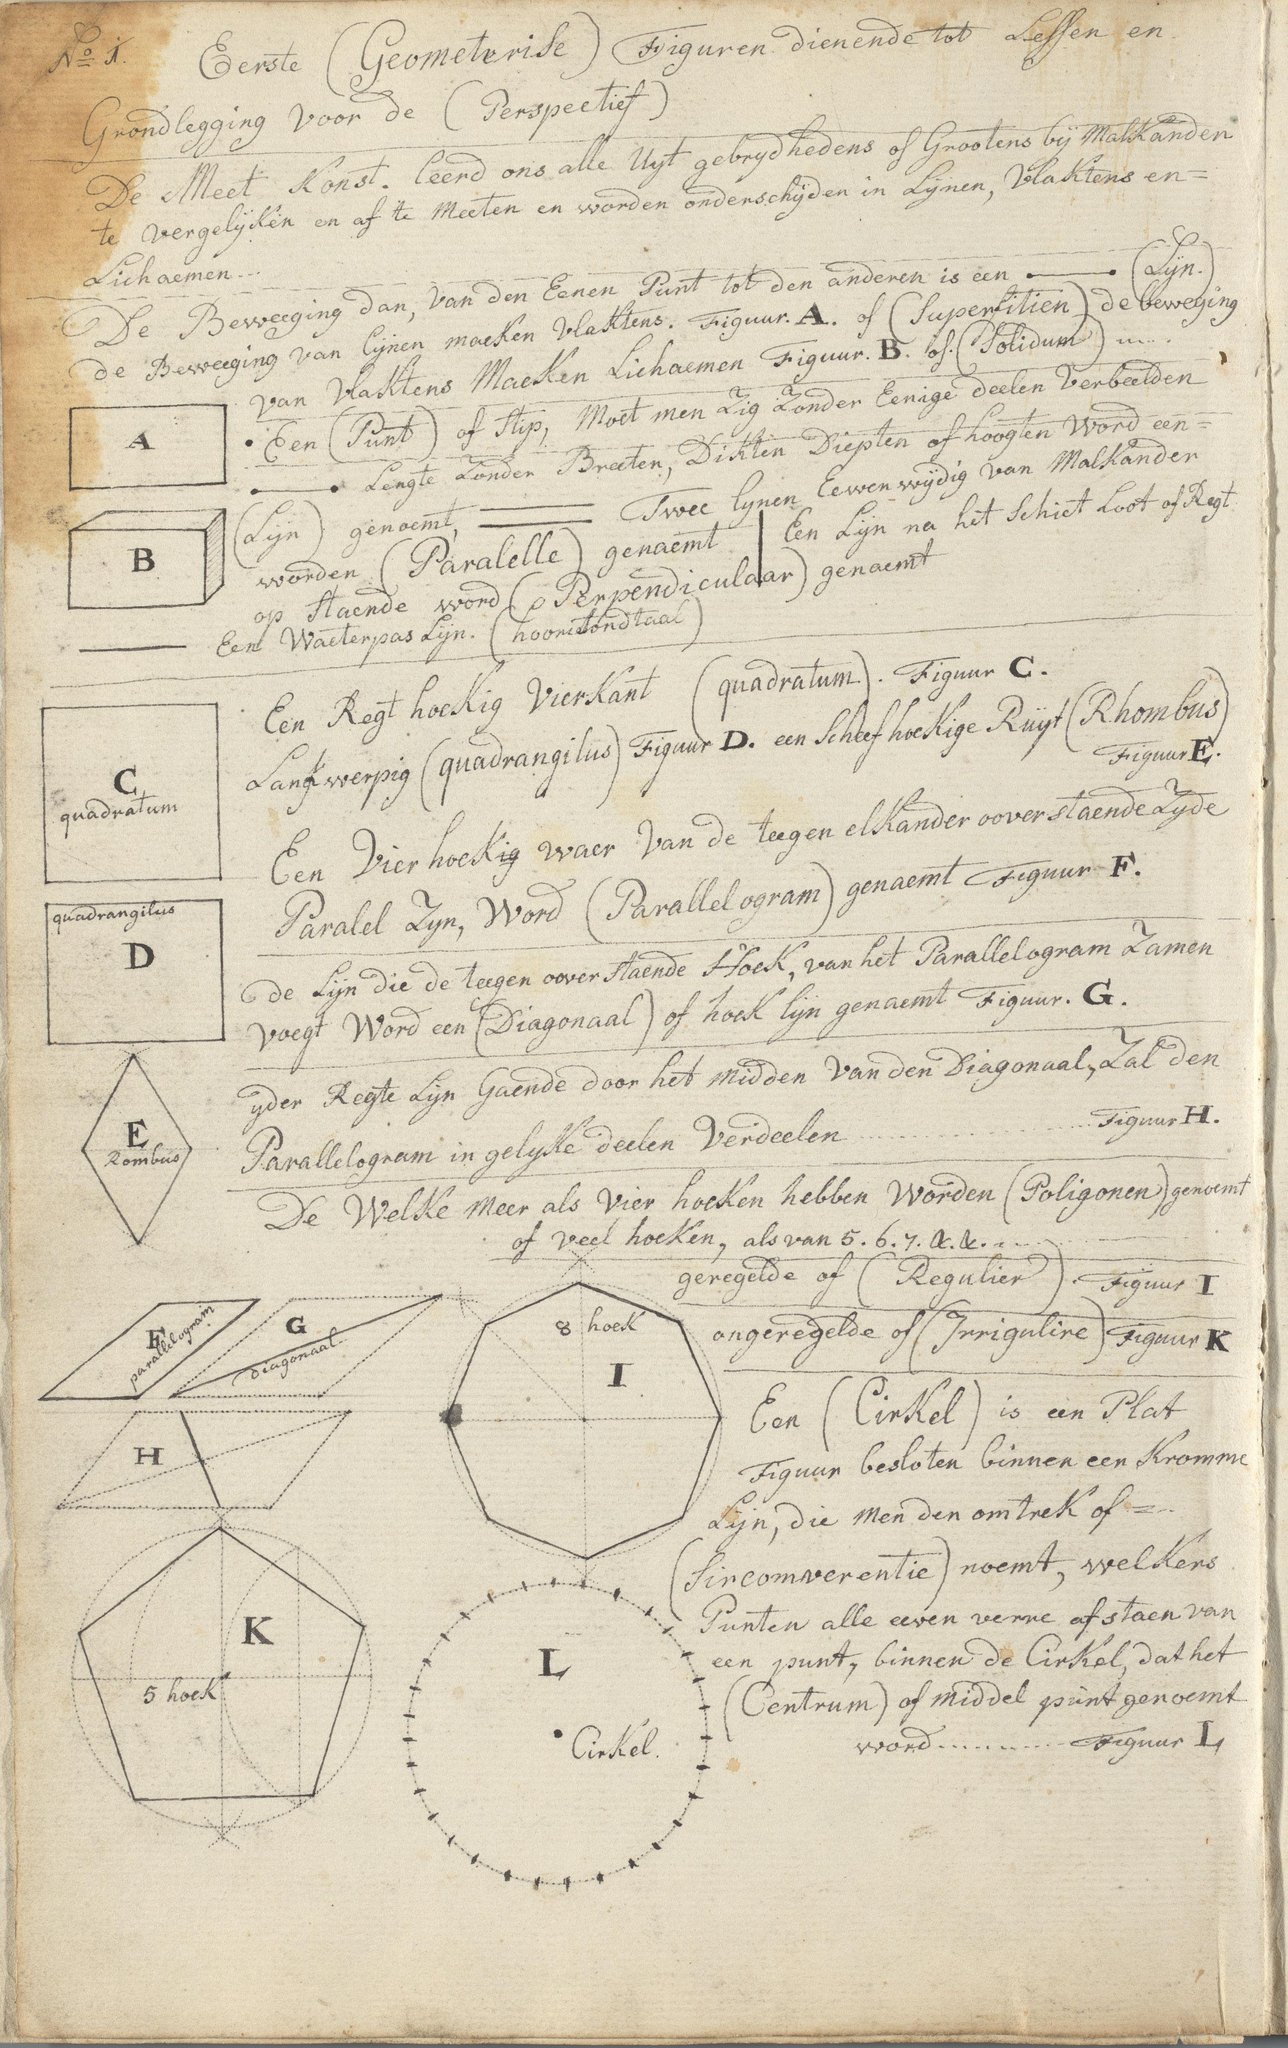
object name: sketchbook leaf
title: Geometrische figuren, voorzien van handgeschreven uitleg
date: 1780-1800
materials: ink, paper, pencil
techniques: drawing, pen, writing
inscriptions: inscription: ‘No 1’, inscription: ‘Eerste (Geometrise) Figuren dienende tot Lessen en / Grondlegging voor de (Perspectief) [...]’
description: Blad 15 verso uit een schetsboek met 17 bladen.